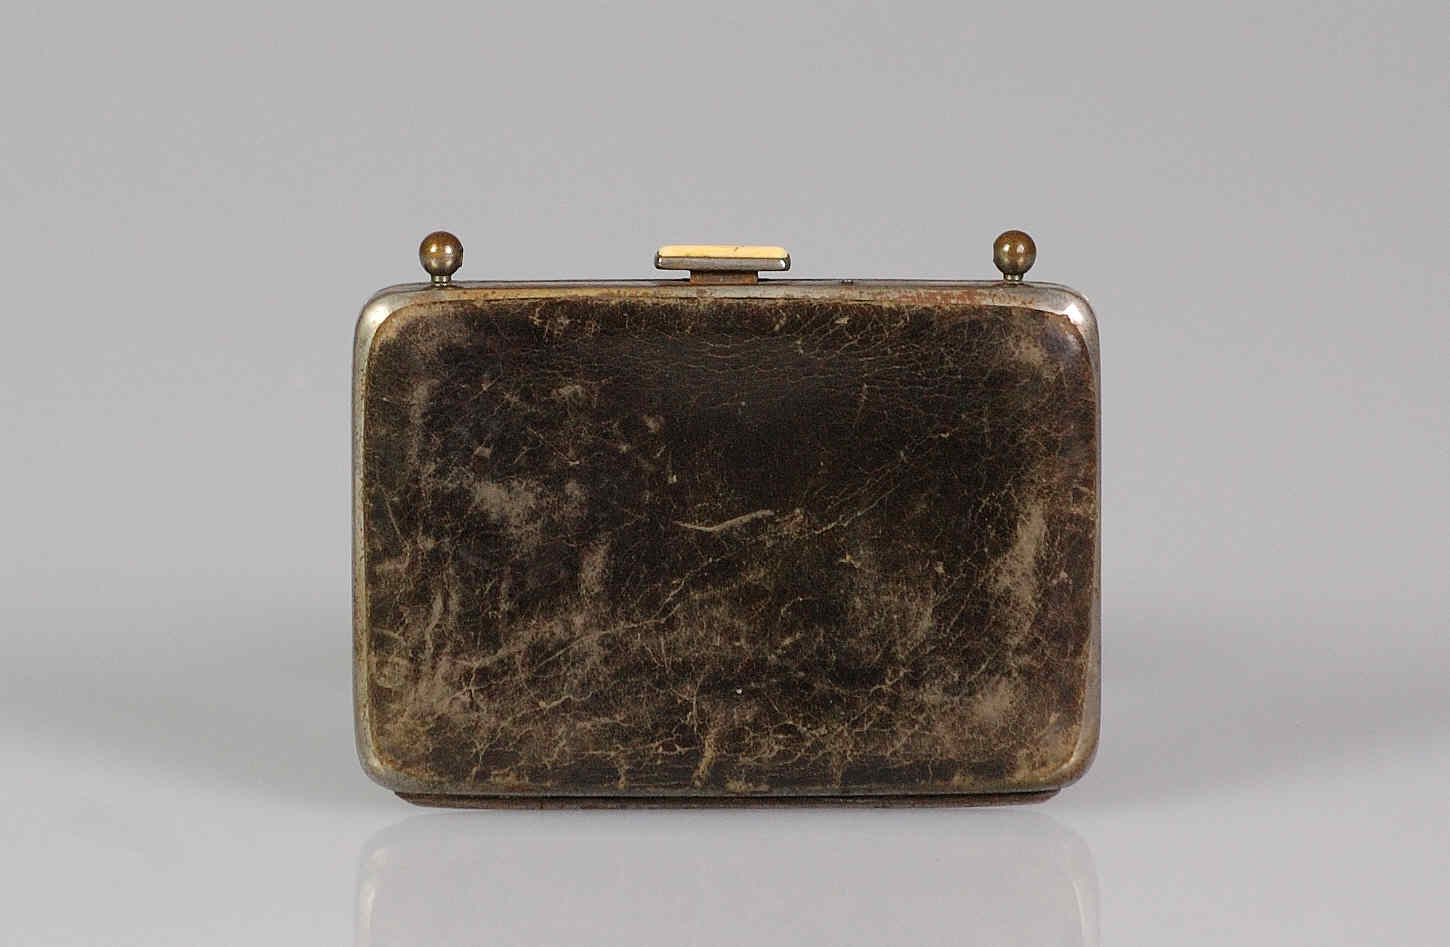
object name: wallet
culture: american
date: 1880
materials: leather, metal